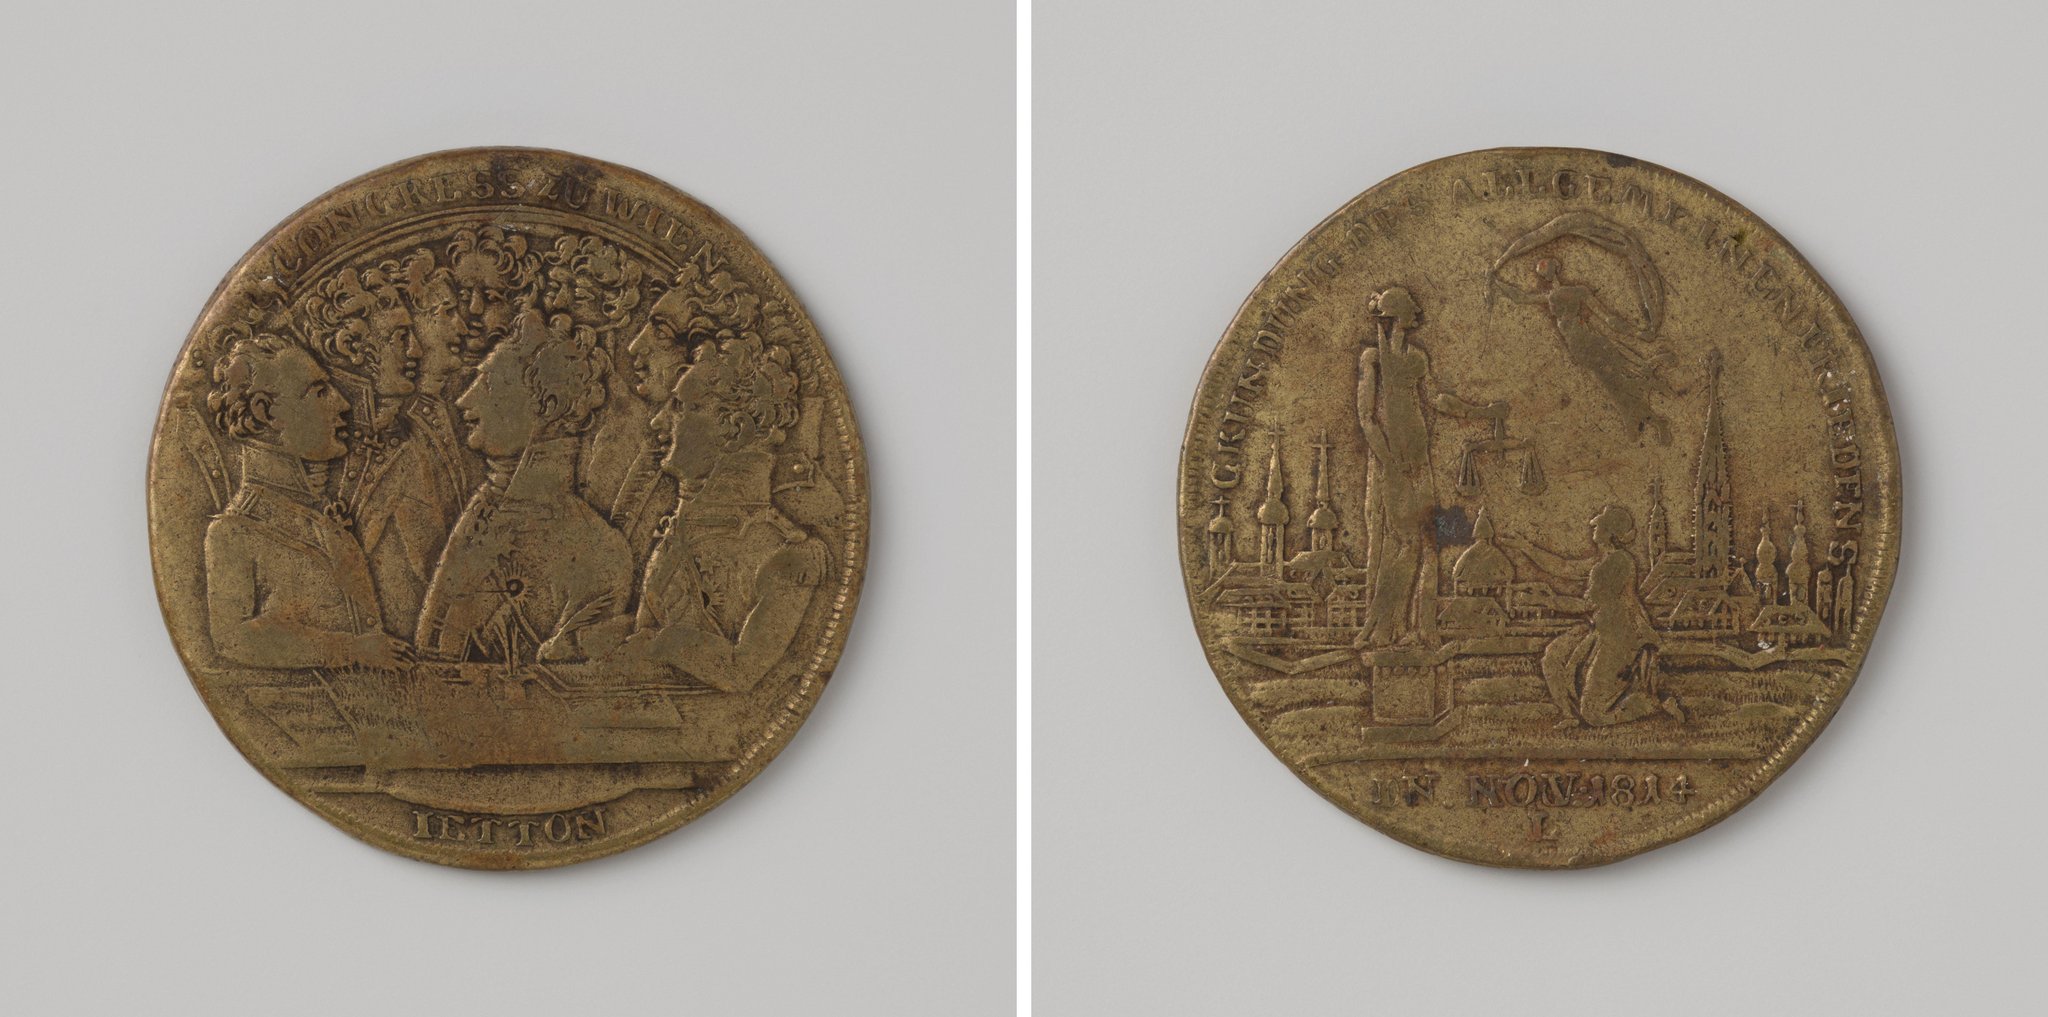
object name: jeton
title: Begin van het Congres van Wenen, ter herordening van Europa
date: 1814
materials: copper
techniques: striking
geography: nuremberg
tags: vienna